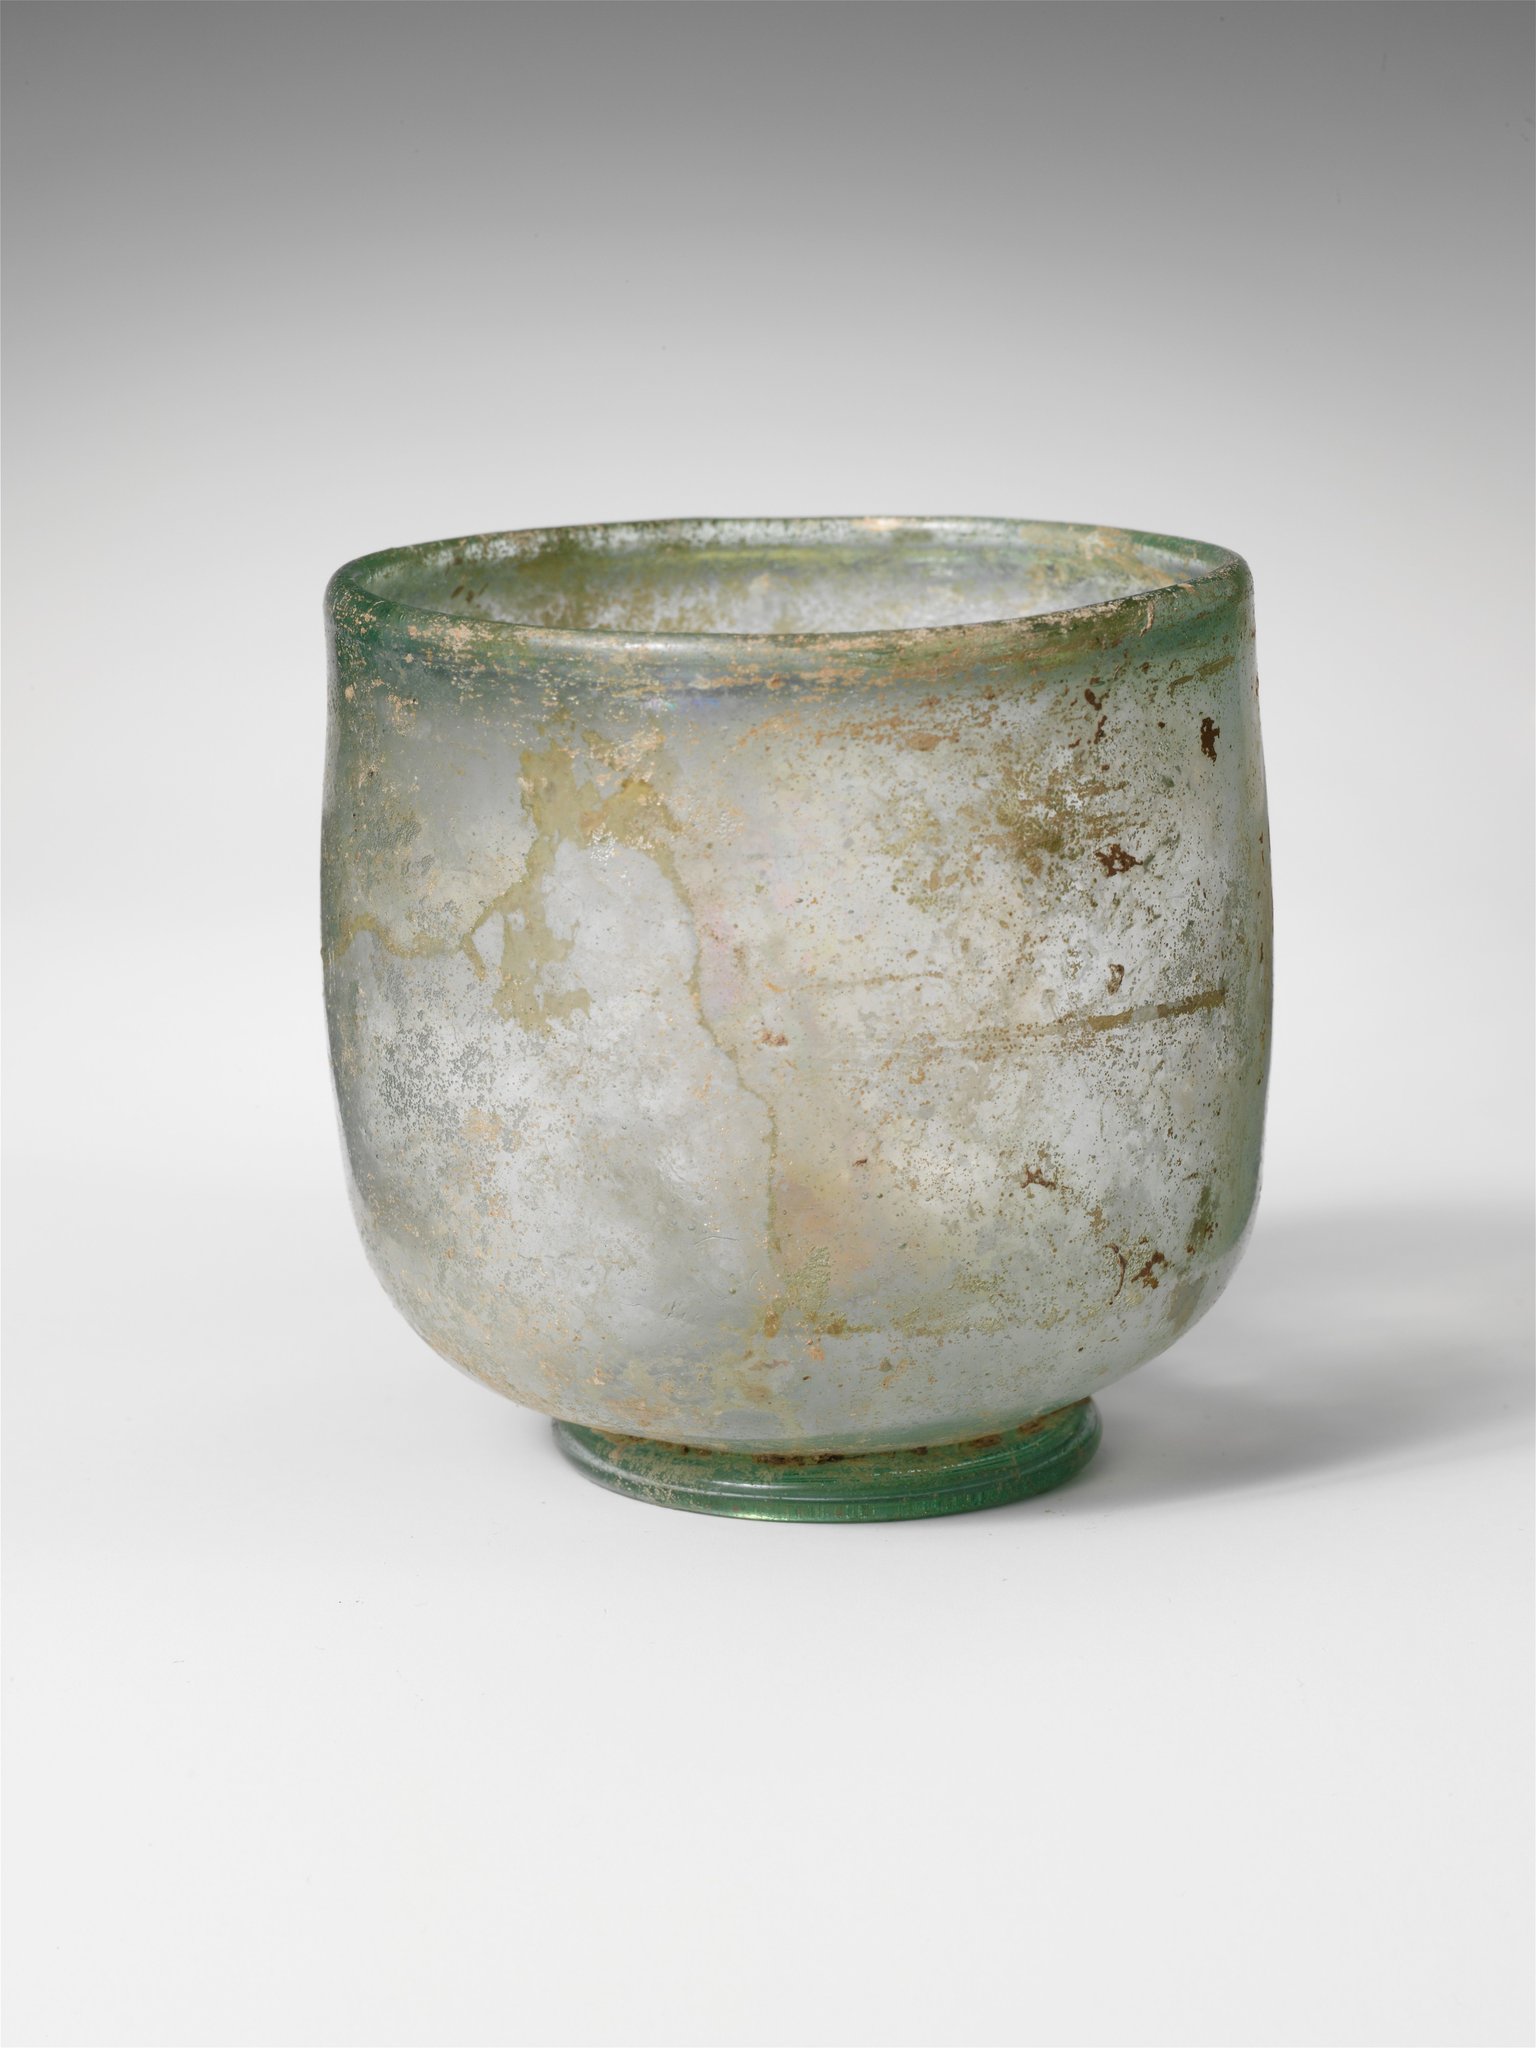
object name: cup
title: Glass cup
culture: roman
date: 201-400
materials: glass